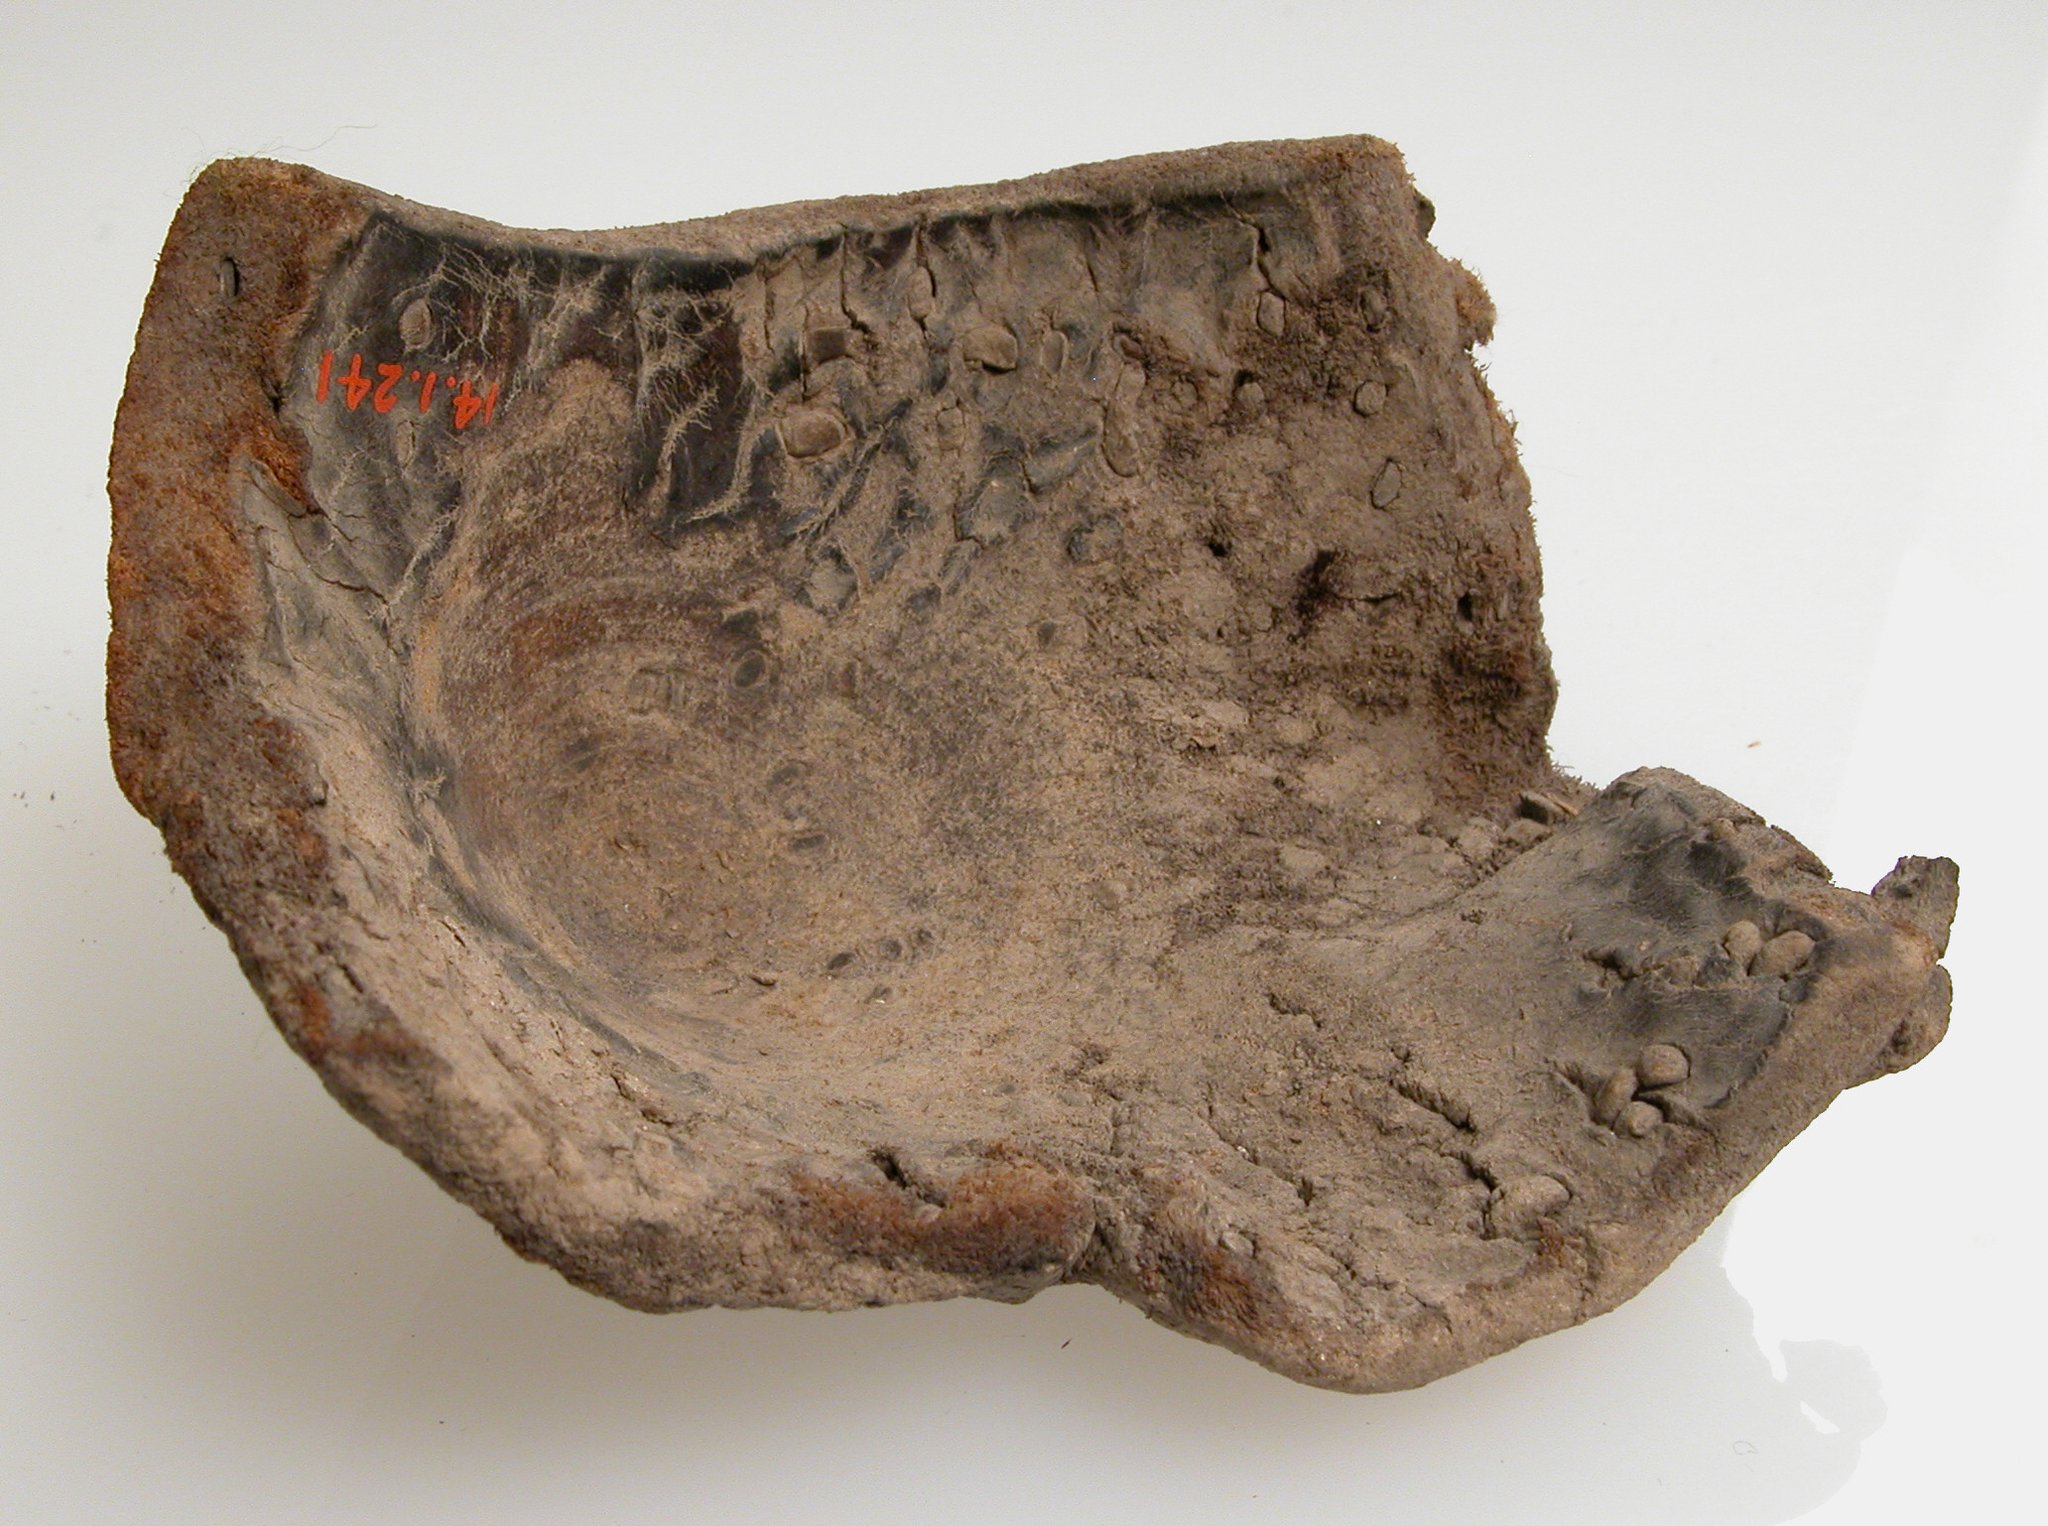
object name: drill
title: Bow-Drill Fragment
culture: coptic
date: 580-640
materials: leather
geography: egypt